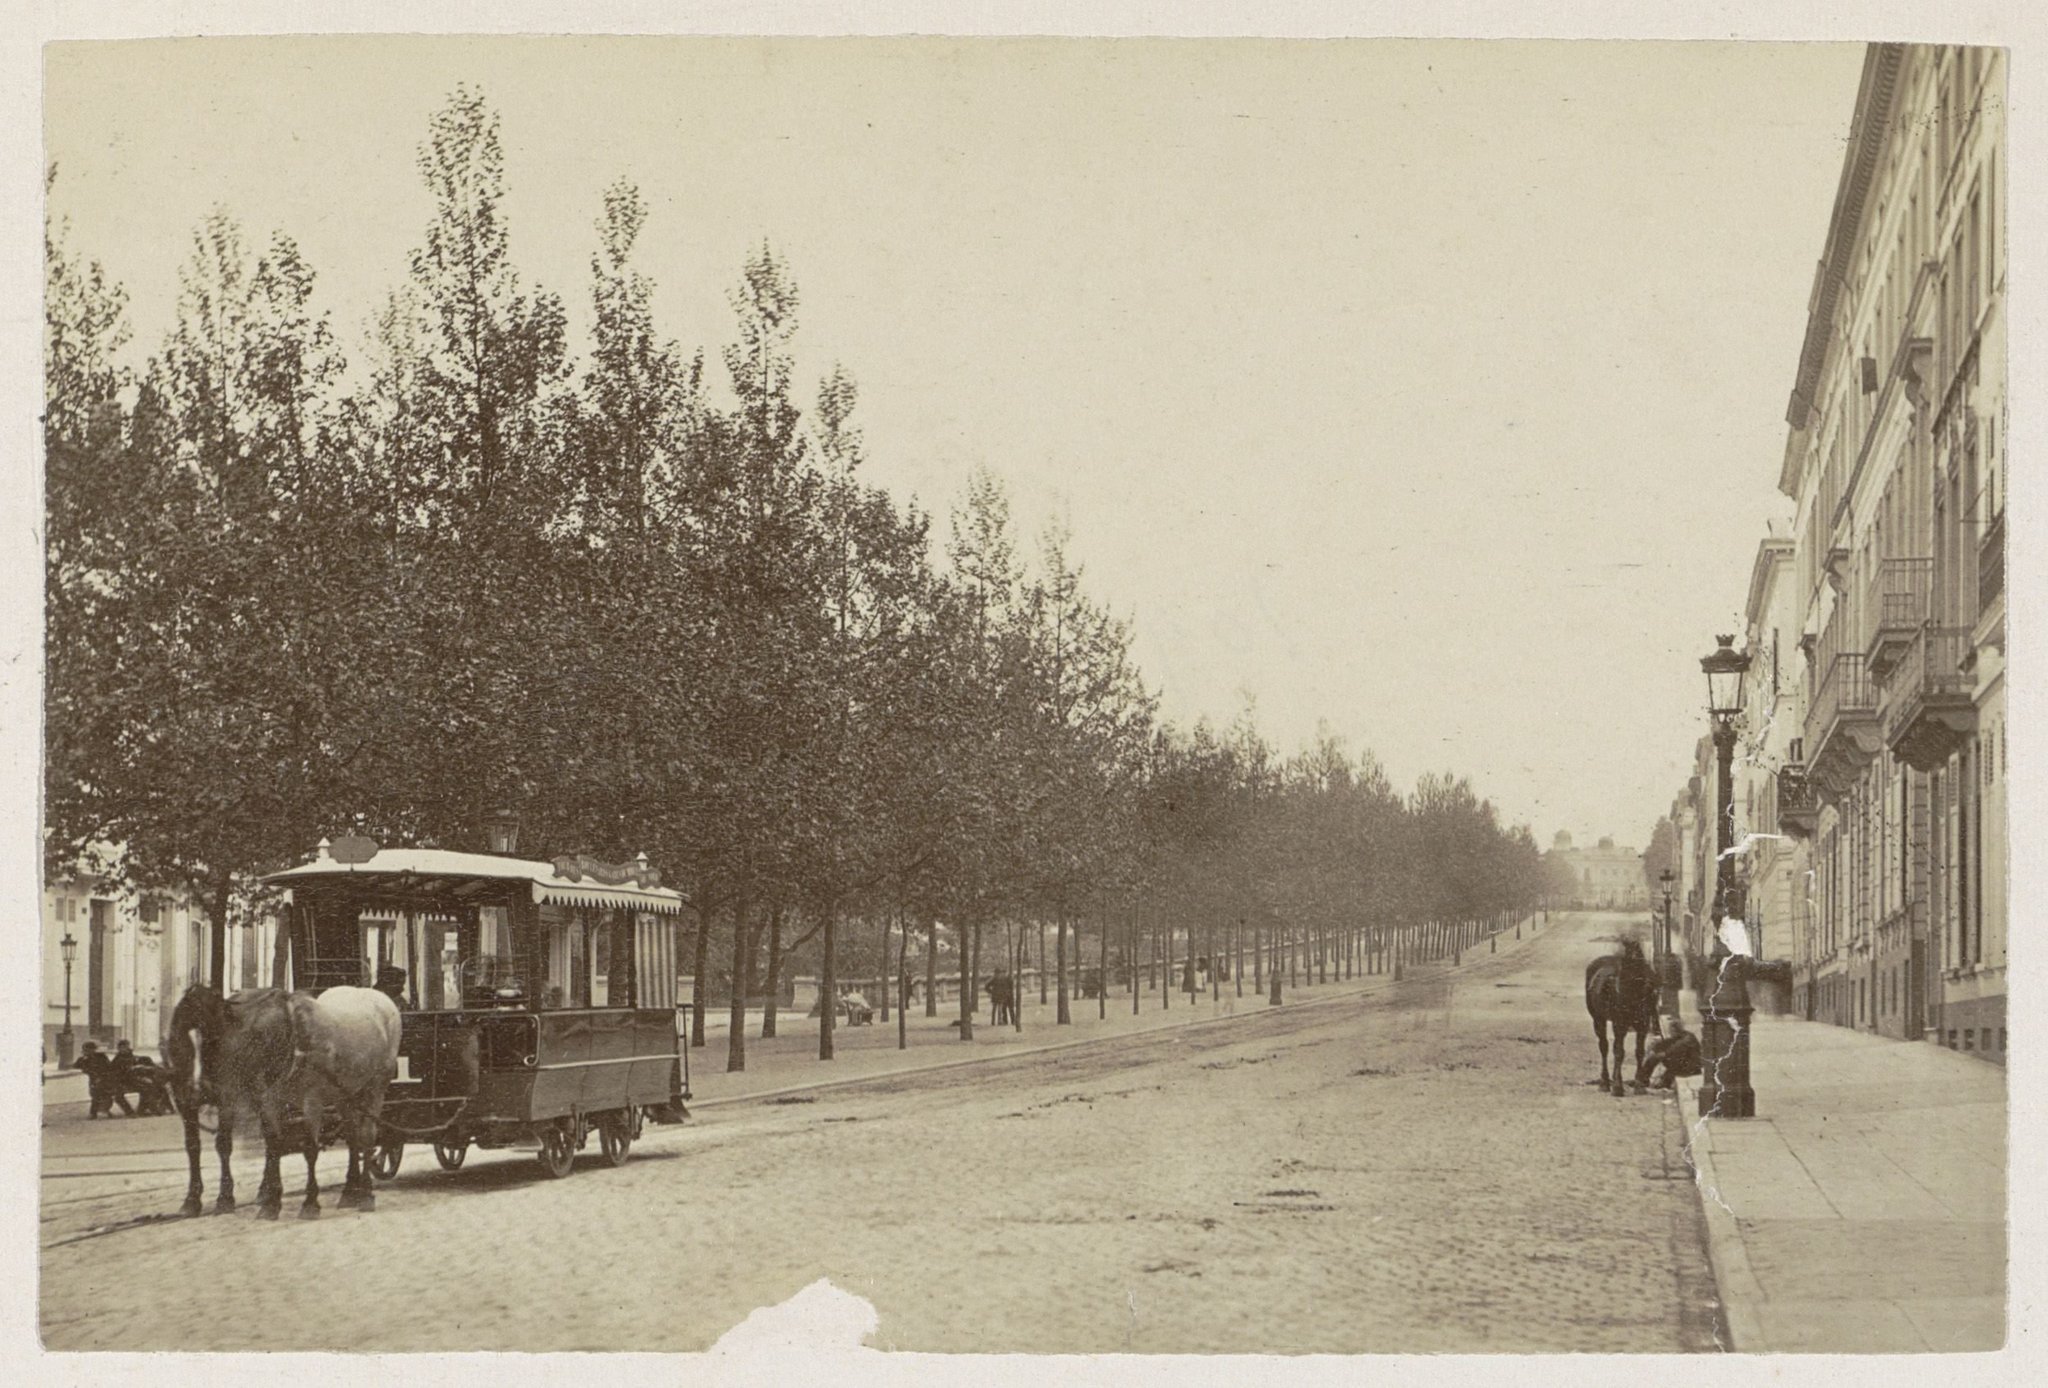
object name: photograph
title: Straat met paardentram, bomen en huizen, vermoedelijk in Brussel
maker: Anonymous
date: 1878-1890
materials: photographic support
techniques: albumen print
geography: brussels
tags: four-wheeled, animal-drawn vehicle, e.g.: cab, carriage, coach (+ conveyance for transport of persons), street (+ city(-scape) with figures, staffage), brussels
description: Onderdeel van Reisalbum Europese steden, vermoedelijk Zweeds.